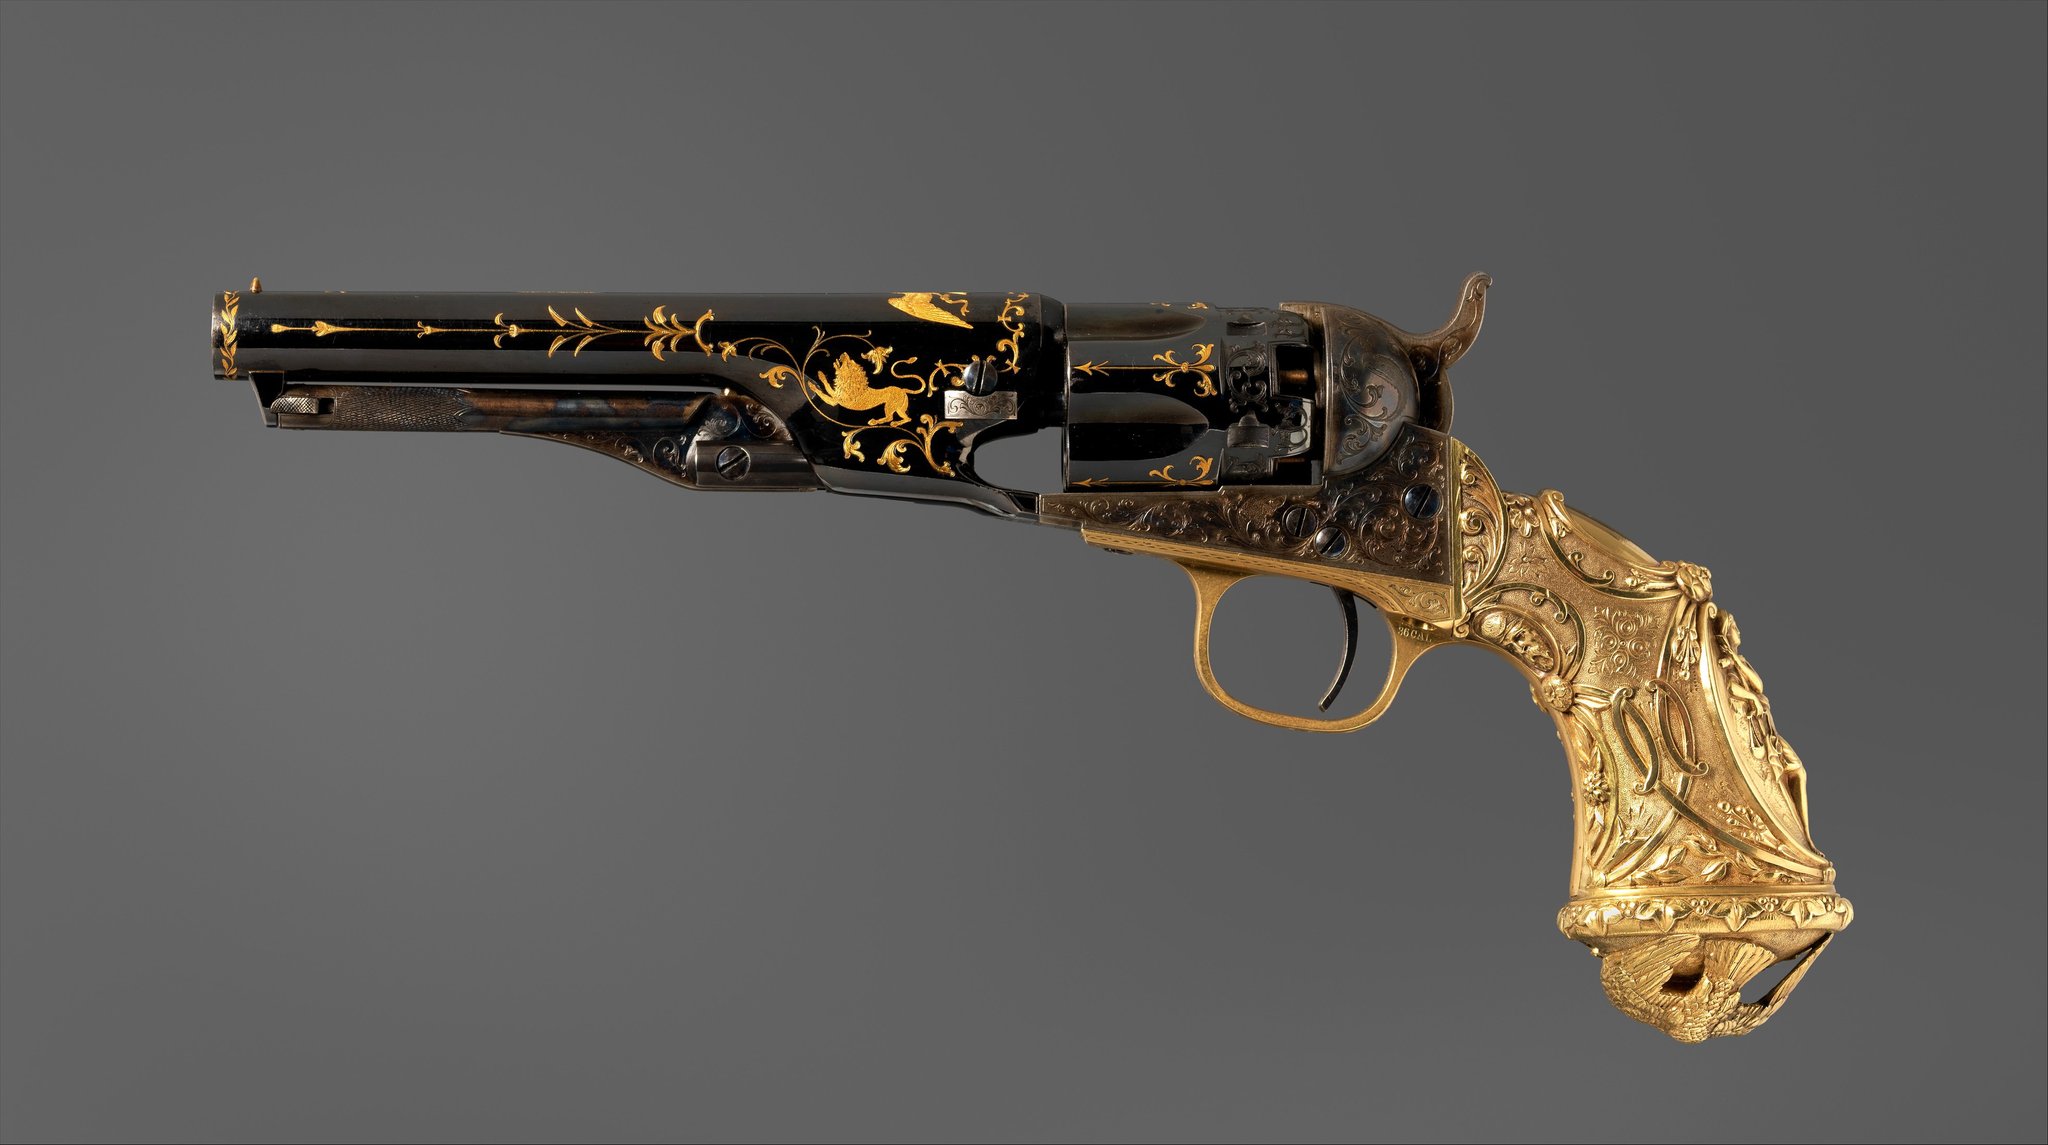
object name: revolver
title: Colt Model 1862 Police Revolver, serial no. 38549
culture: american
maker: colt's patent fire arms manufacturing company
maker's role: manufacturer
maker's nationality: american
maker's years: 1855-2014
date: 1868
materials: copper alloy, gold, steel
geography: united states